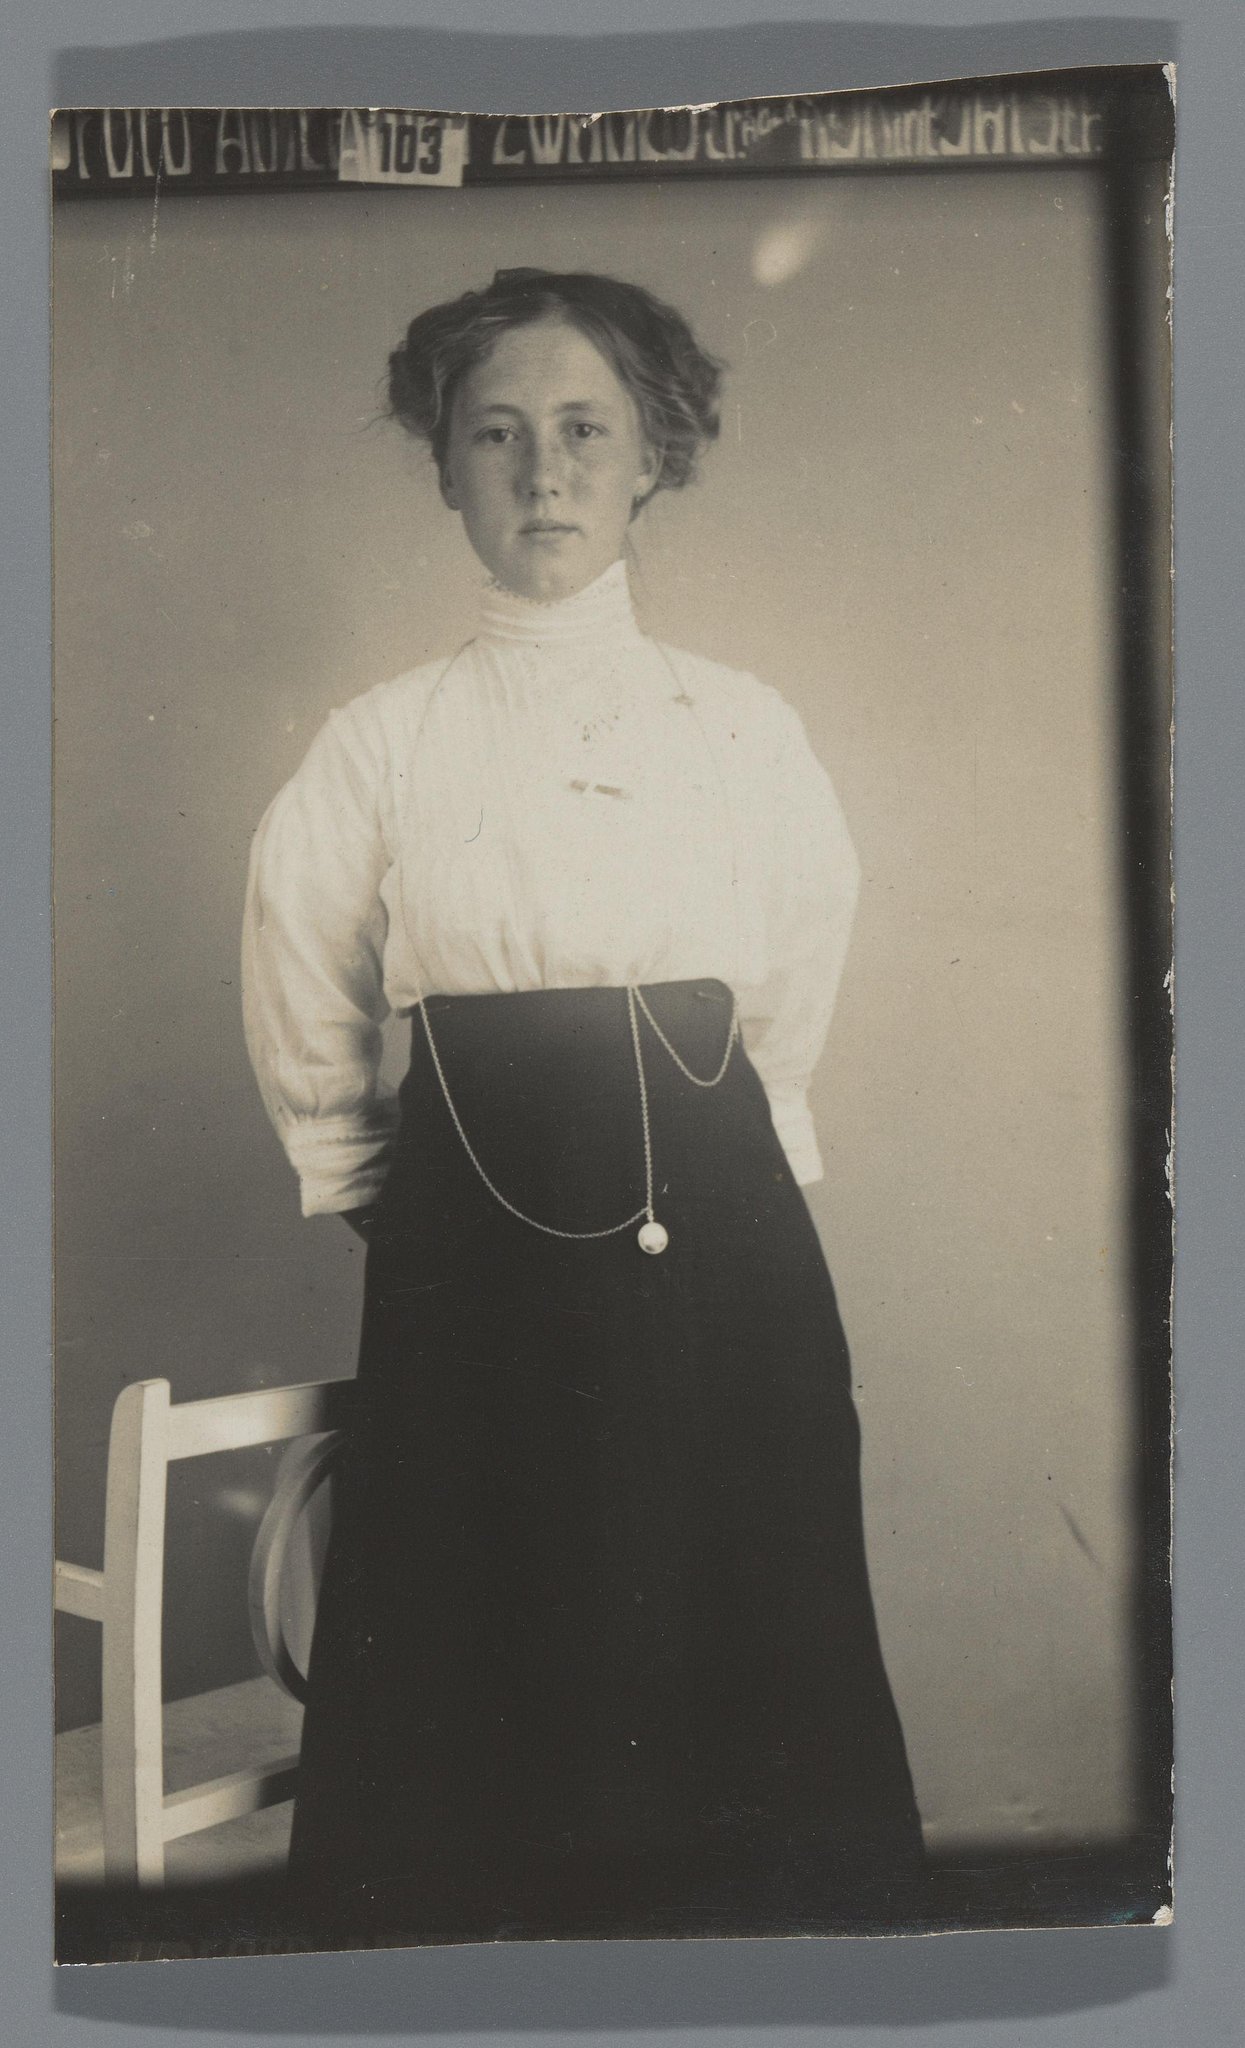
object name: snapshot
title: Rapid photographs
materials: photographic support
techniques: gelatin silver print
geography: groningen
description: Between 1912 and 1930, anyone could have their portrait taken at the many so-called rapid photography studios in the shopping streets of mainly (medium) large-size European cities. As if on an assembly line, the youngest clerk shot the photographs with a special camera and in artificial light and developed them. Later in the day, the customer collected a sheet with 12 portrait photos for 25 cents. This form of photographic mass production gave rise to a fascinating tableau of boys, girls, men and women not previously seen in photographs; candid and informal. There were at least 150 quick-photo studios, from Alkmaar to Zutphen. Many called themselves ‘American,’ mistakenly as it turns out because hardly any examples from that country have been found.